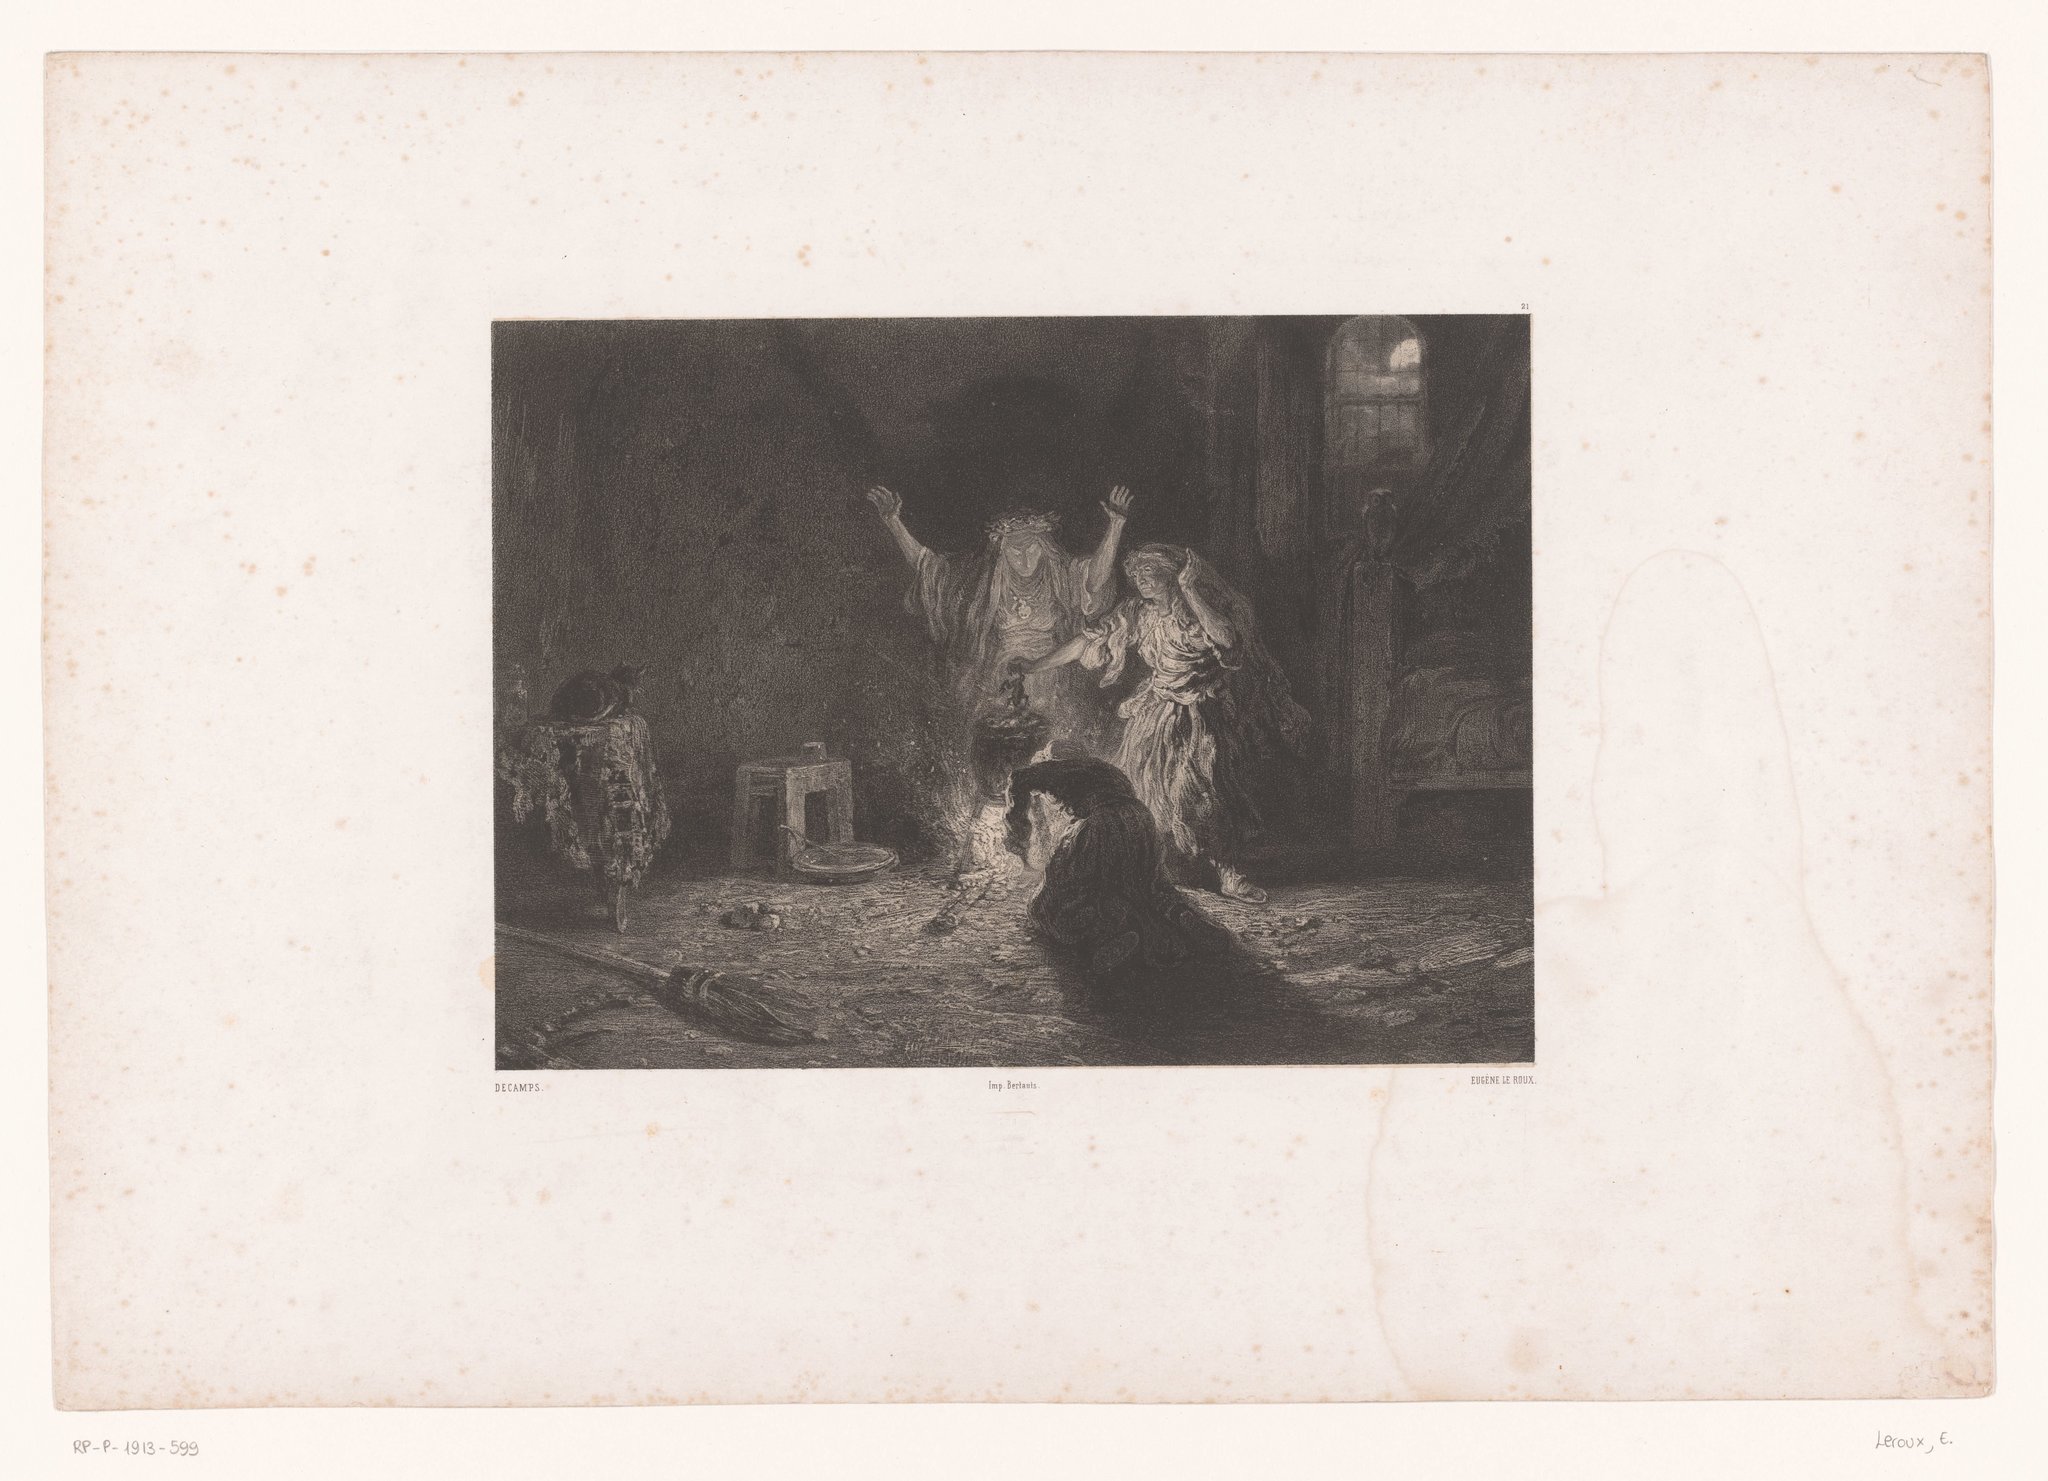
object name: print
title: Drie heksen uit Shakespeares Macbeth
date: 1846-1848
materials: paper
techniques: lithography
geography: paris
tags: groups of witches, macbeth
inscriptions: check stamp: Lugt 36b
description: Prent gebruikt voor: Les Artistes contemporains, dl. 1, 1846-1848.